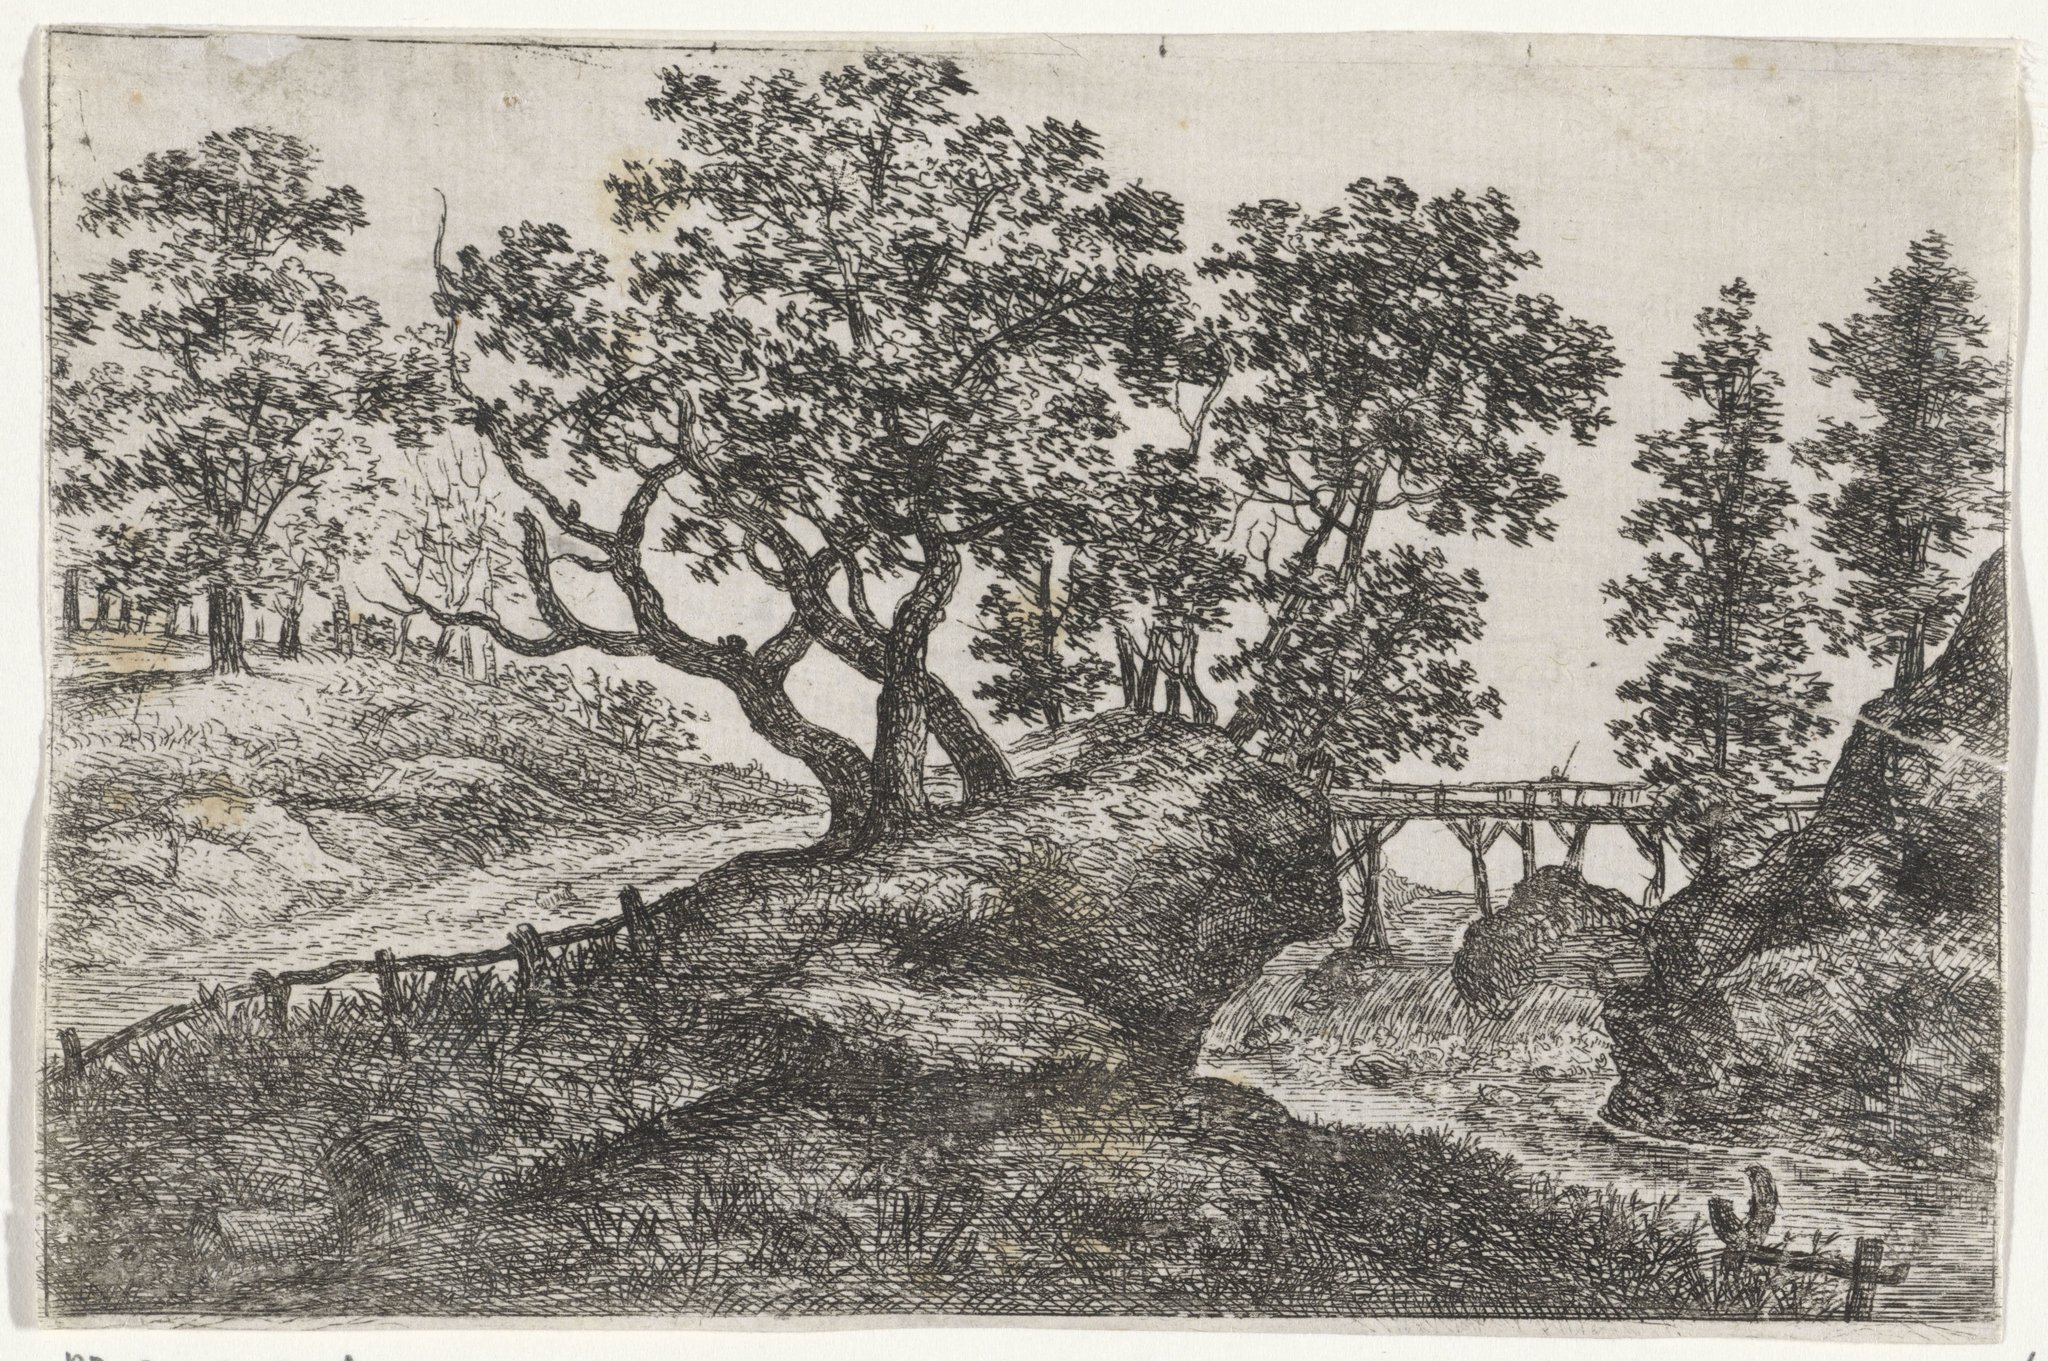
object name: print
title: Landschap met een houten brug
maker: jean vaillant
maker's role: print maker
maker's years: 1627-1668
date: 1637-1674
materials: paper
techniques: etching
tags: landscape with bridge, viaduct or aqueduct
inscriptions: collector's mark: Lugt 964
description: Landschap met bomen en een rivier waarover een houten brug. Tweede prent uit een serie van zes prenten met landschappen.